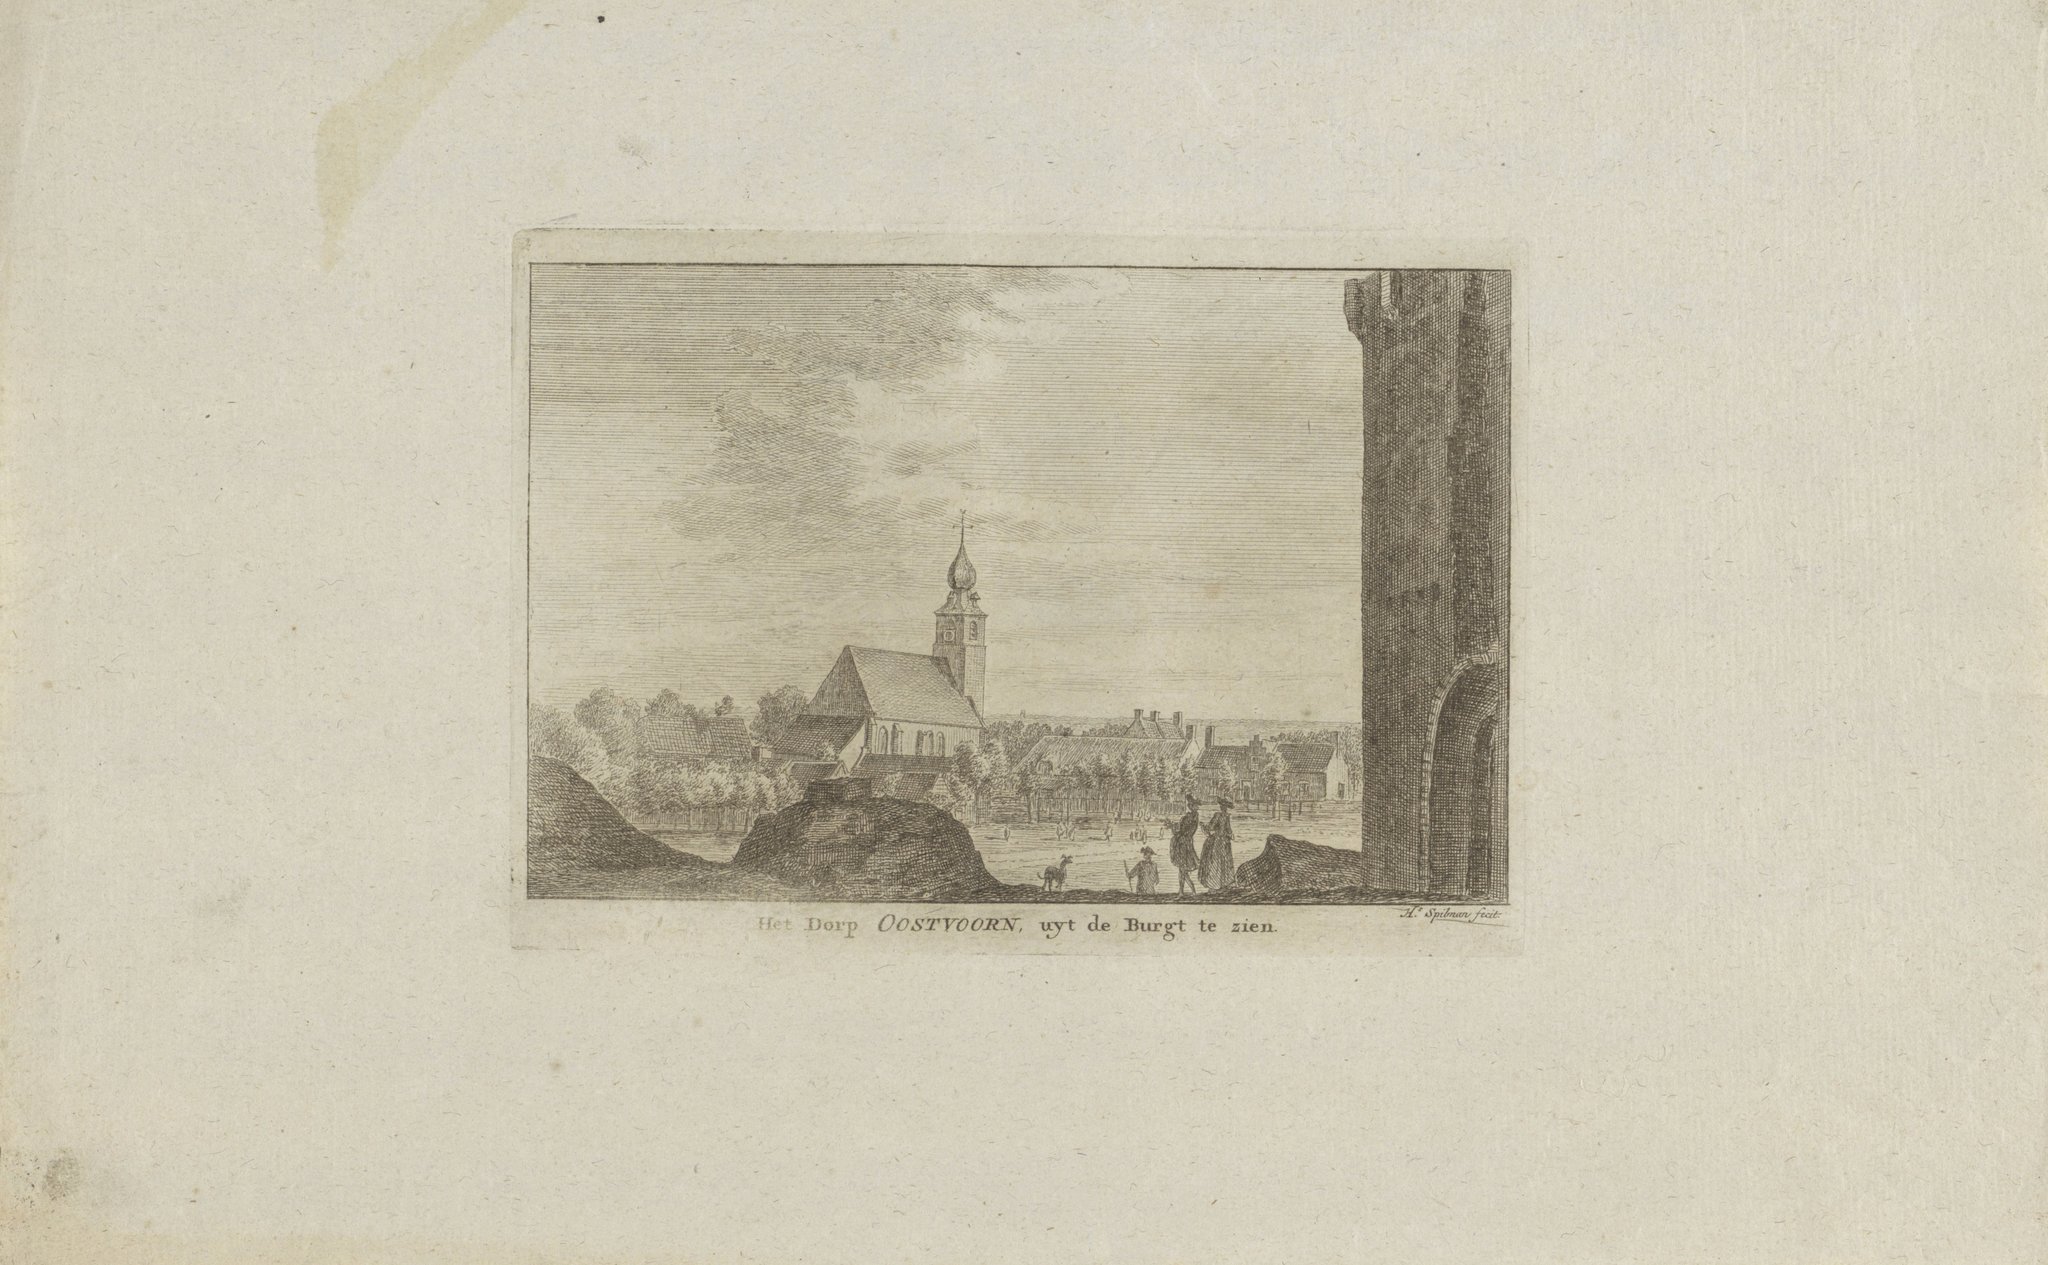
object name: print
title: Gezicht op Oostvoorne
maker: hendrik spilman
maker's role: draughtsman, painter, print maker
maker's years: 1721-1784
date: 1742-1784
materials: paper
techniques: etching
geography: haarlem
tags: church (exterior), oostvoorne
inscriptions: collector's mark: Lugt 2228